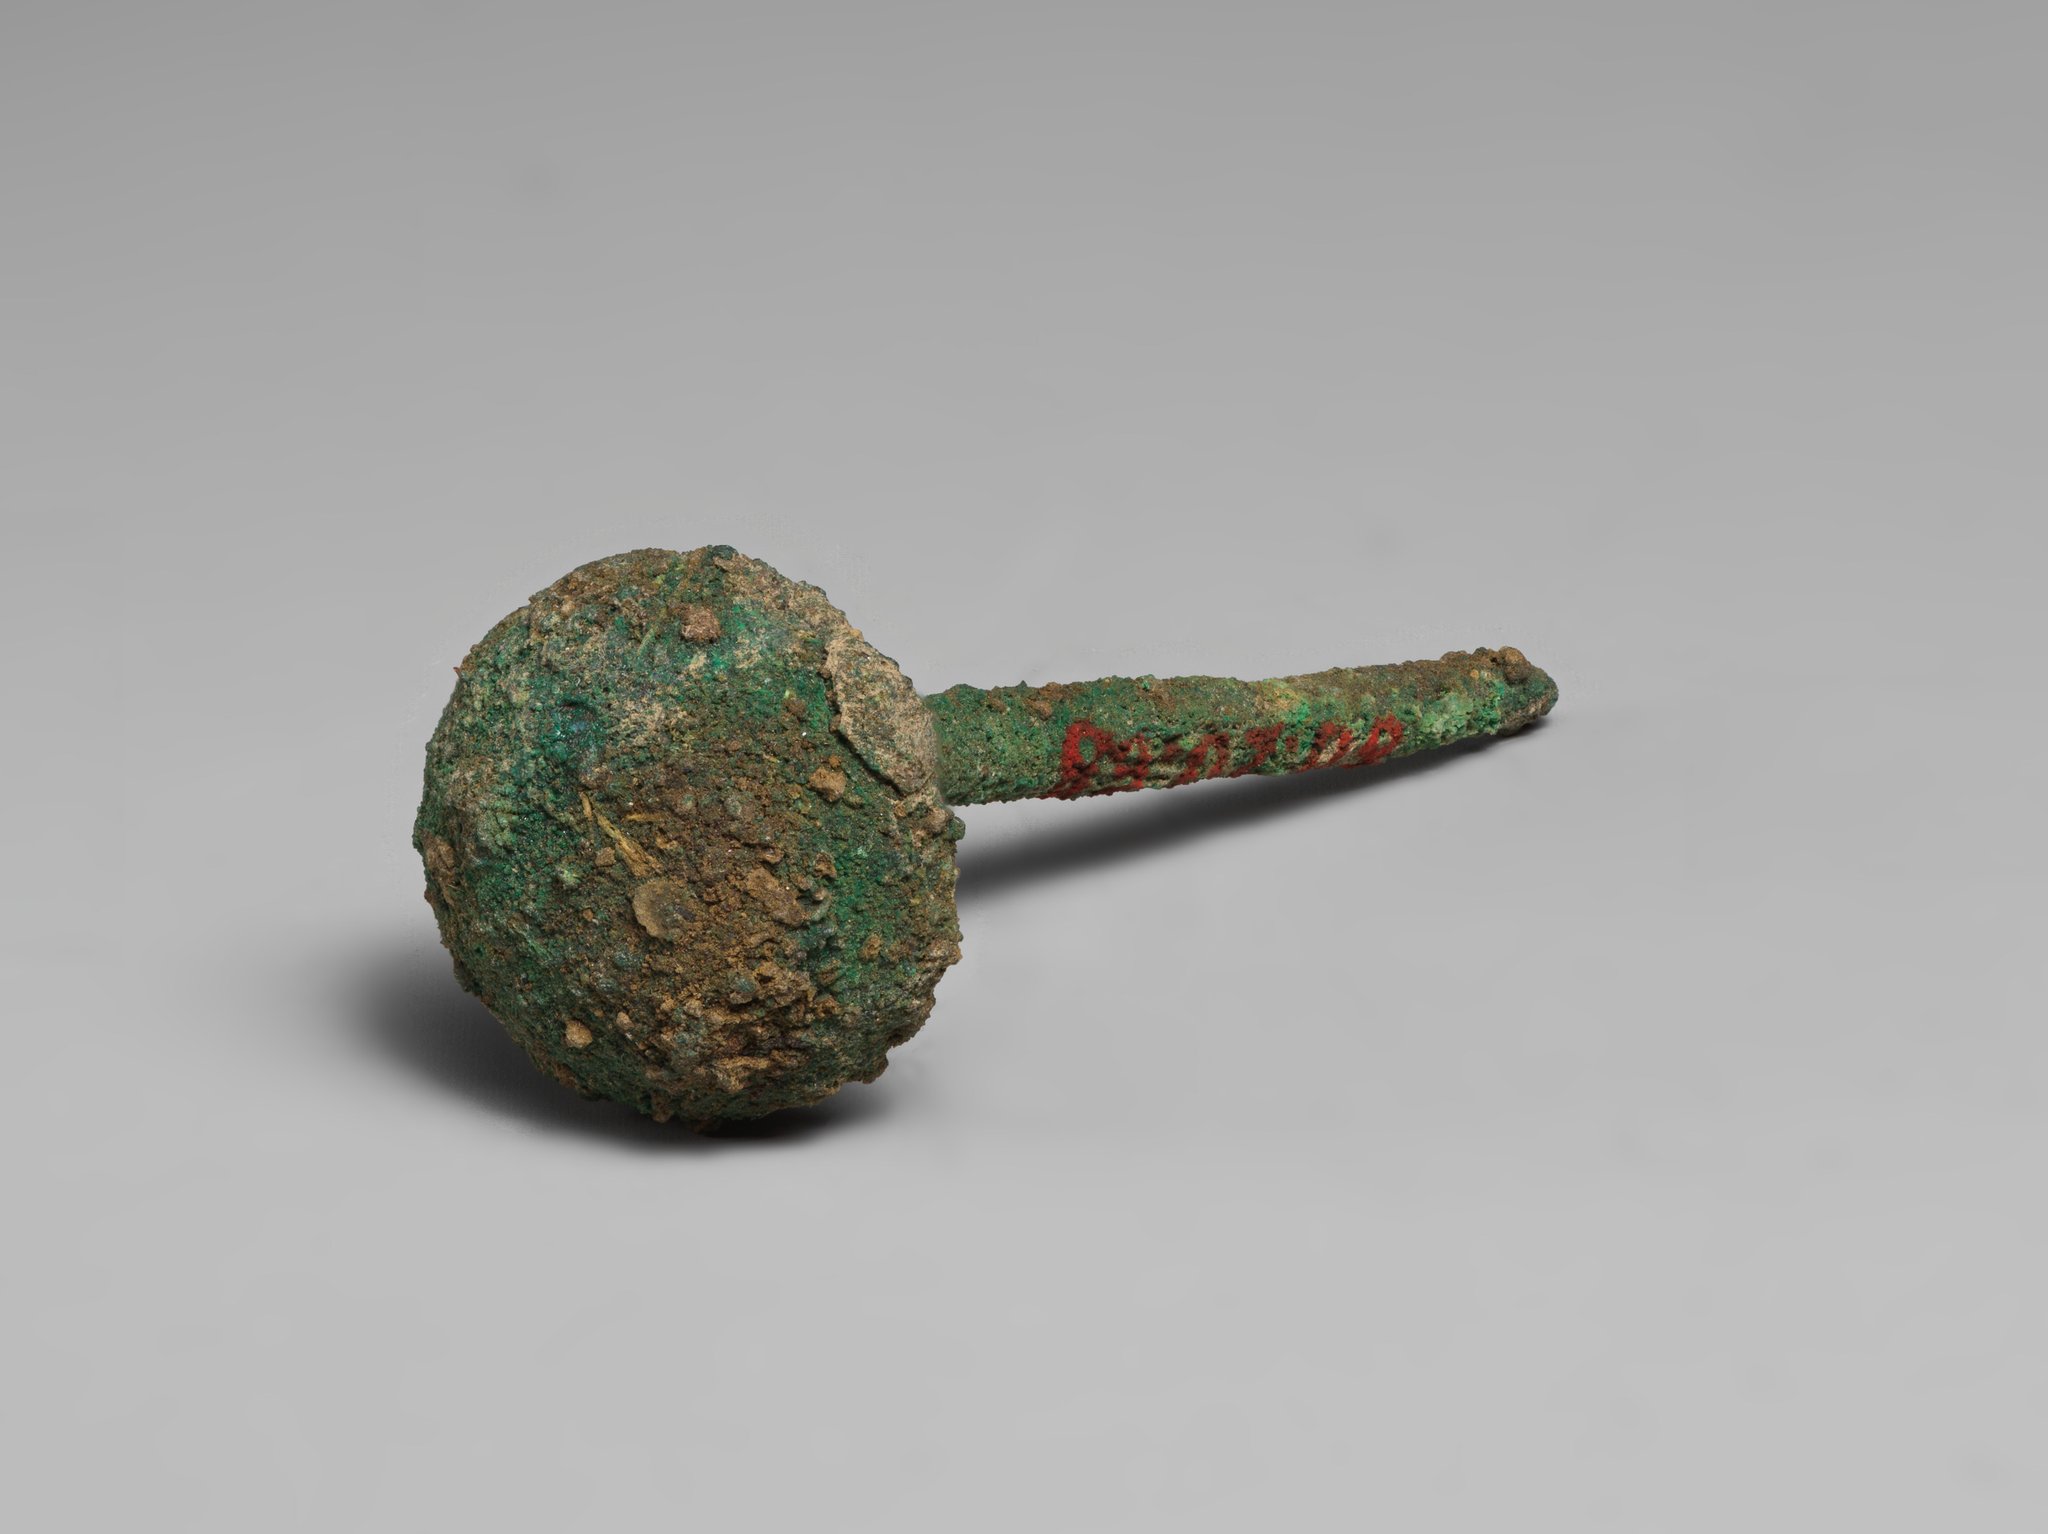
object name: stud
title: Studs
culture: iranian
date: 900-801 BCE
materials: bronze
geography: iran